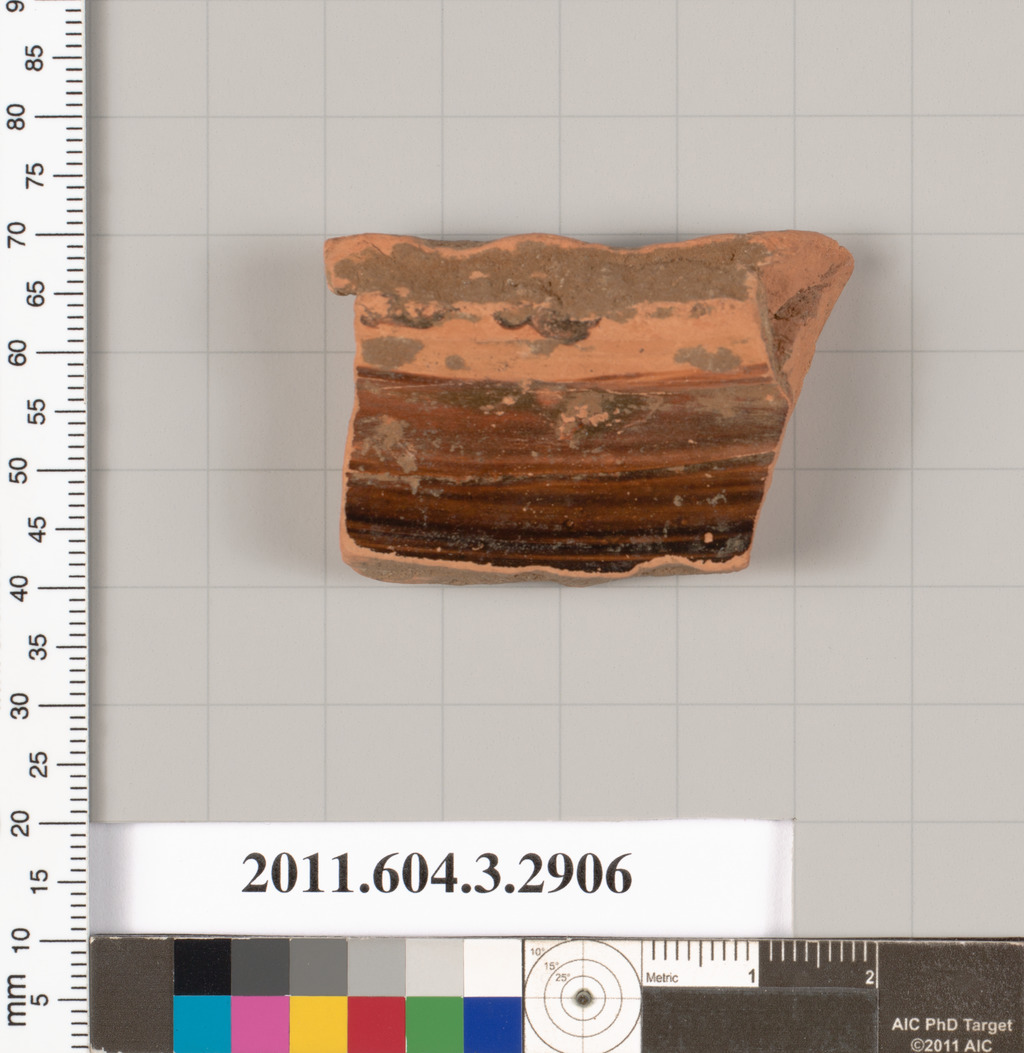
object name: undetermined open vase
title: Terracotta fragment of an open vase?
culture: greek, attic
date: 600-401 BCE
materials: terracotta